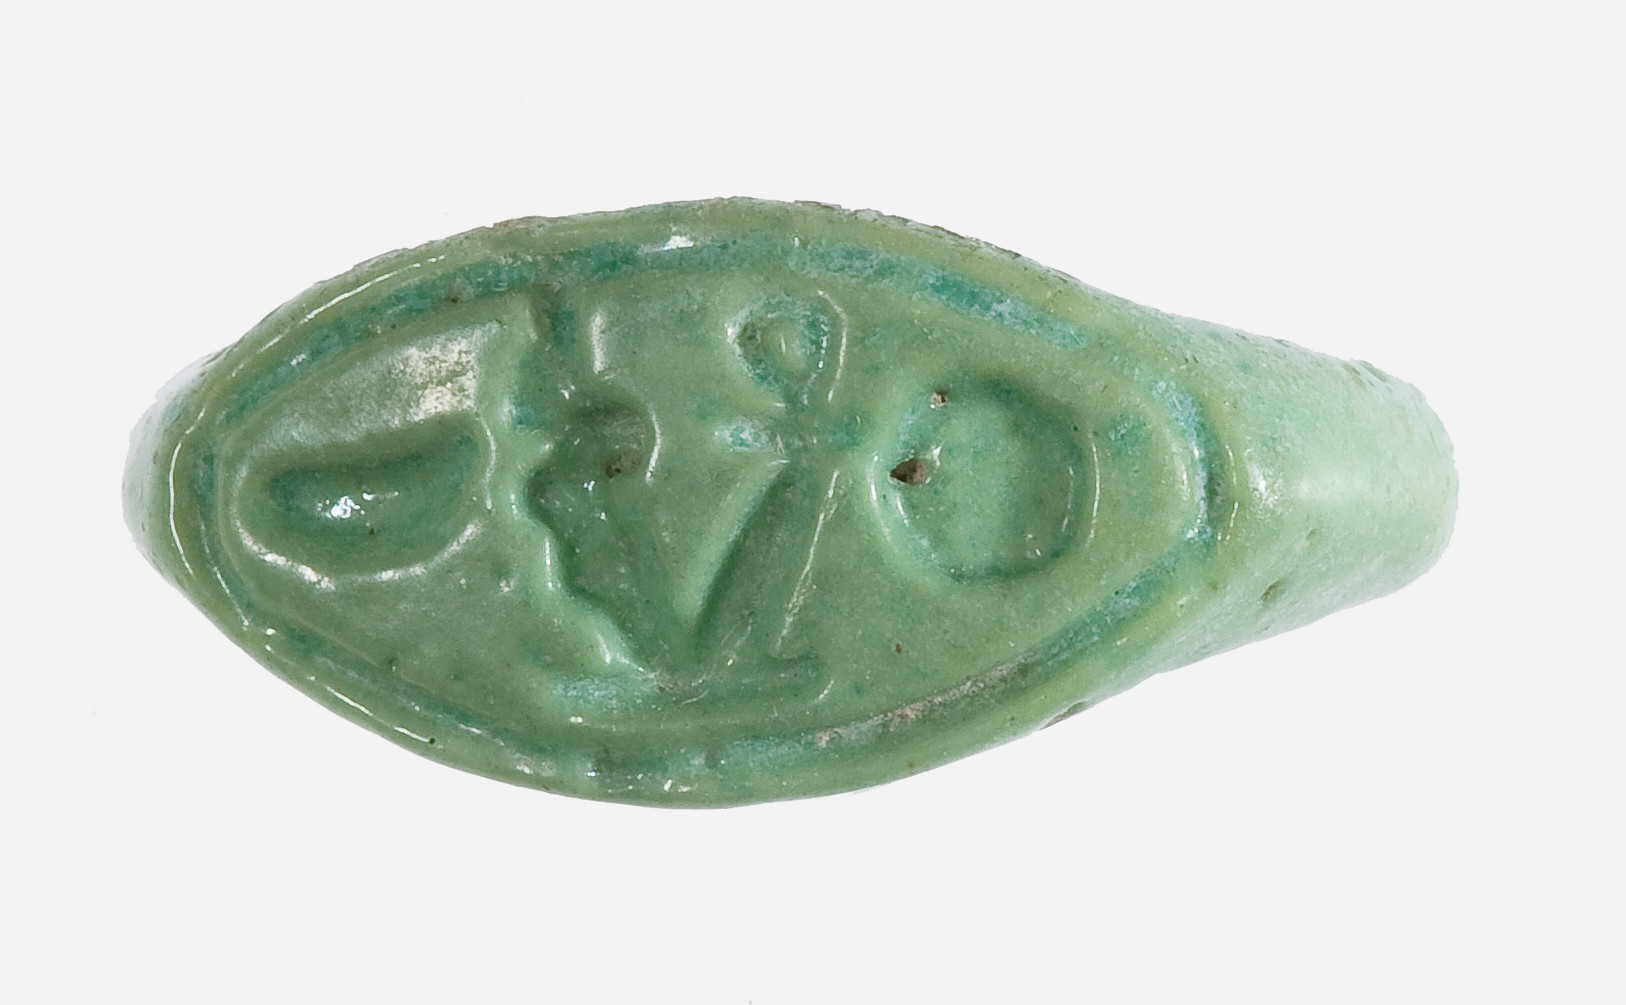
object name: ring, amenhotep iii prenomen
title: Ring, Prenomen of Amenhotep III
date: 1390-1352 BCE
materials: faience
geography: egypt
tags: hieroglyphs